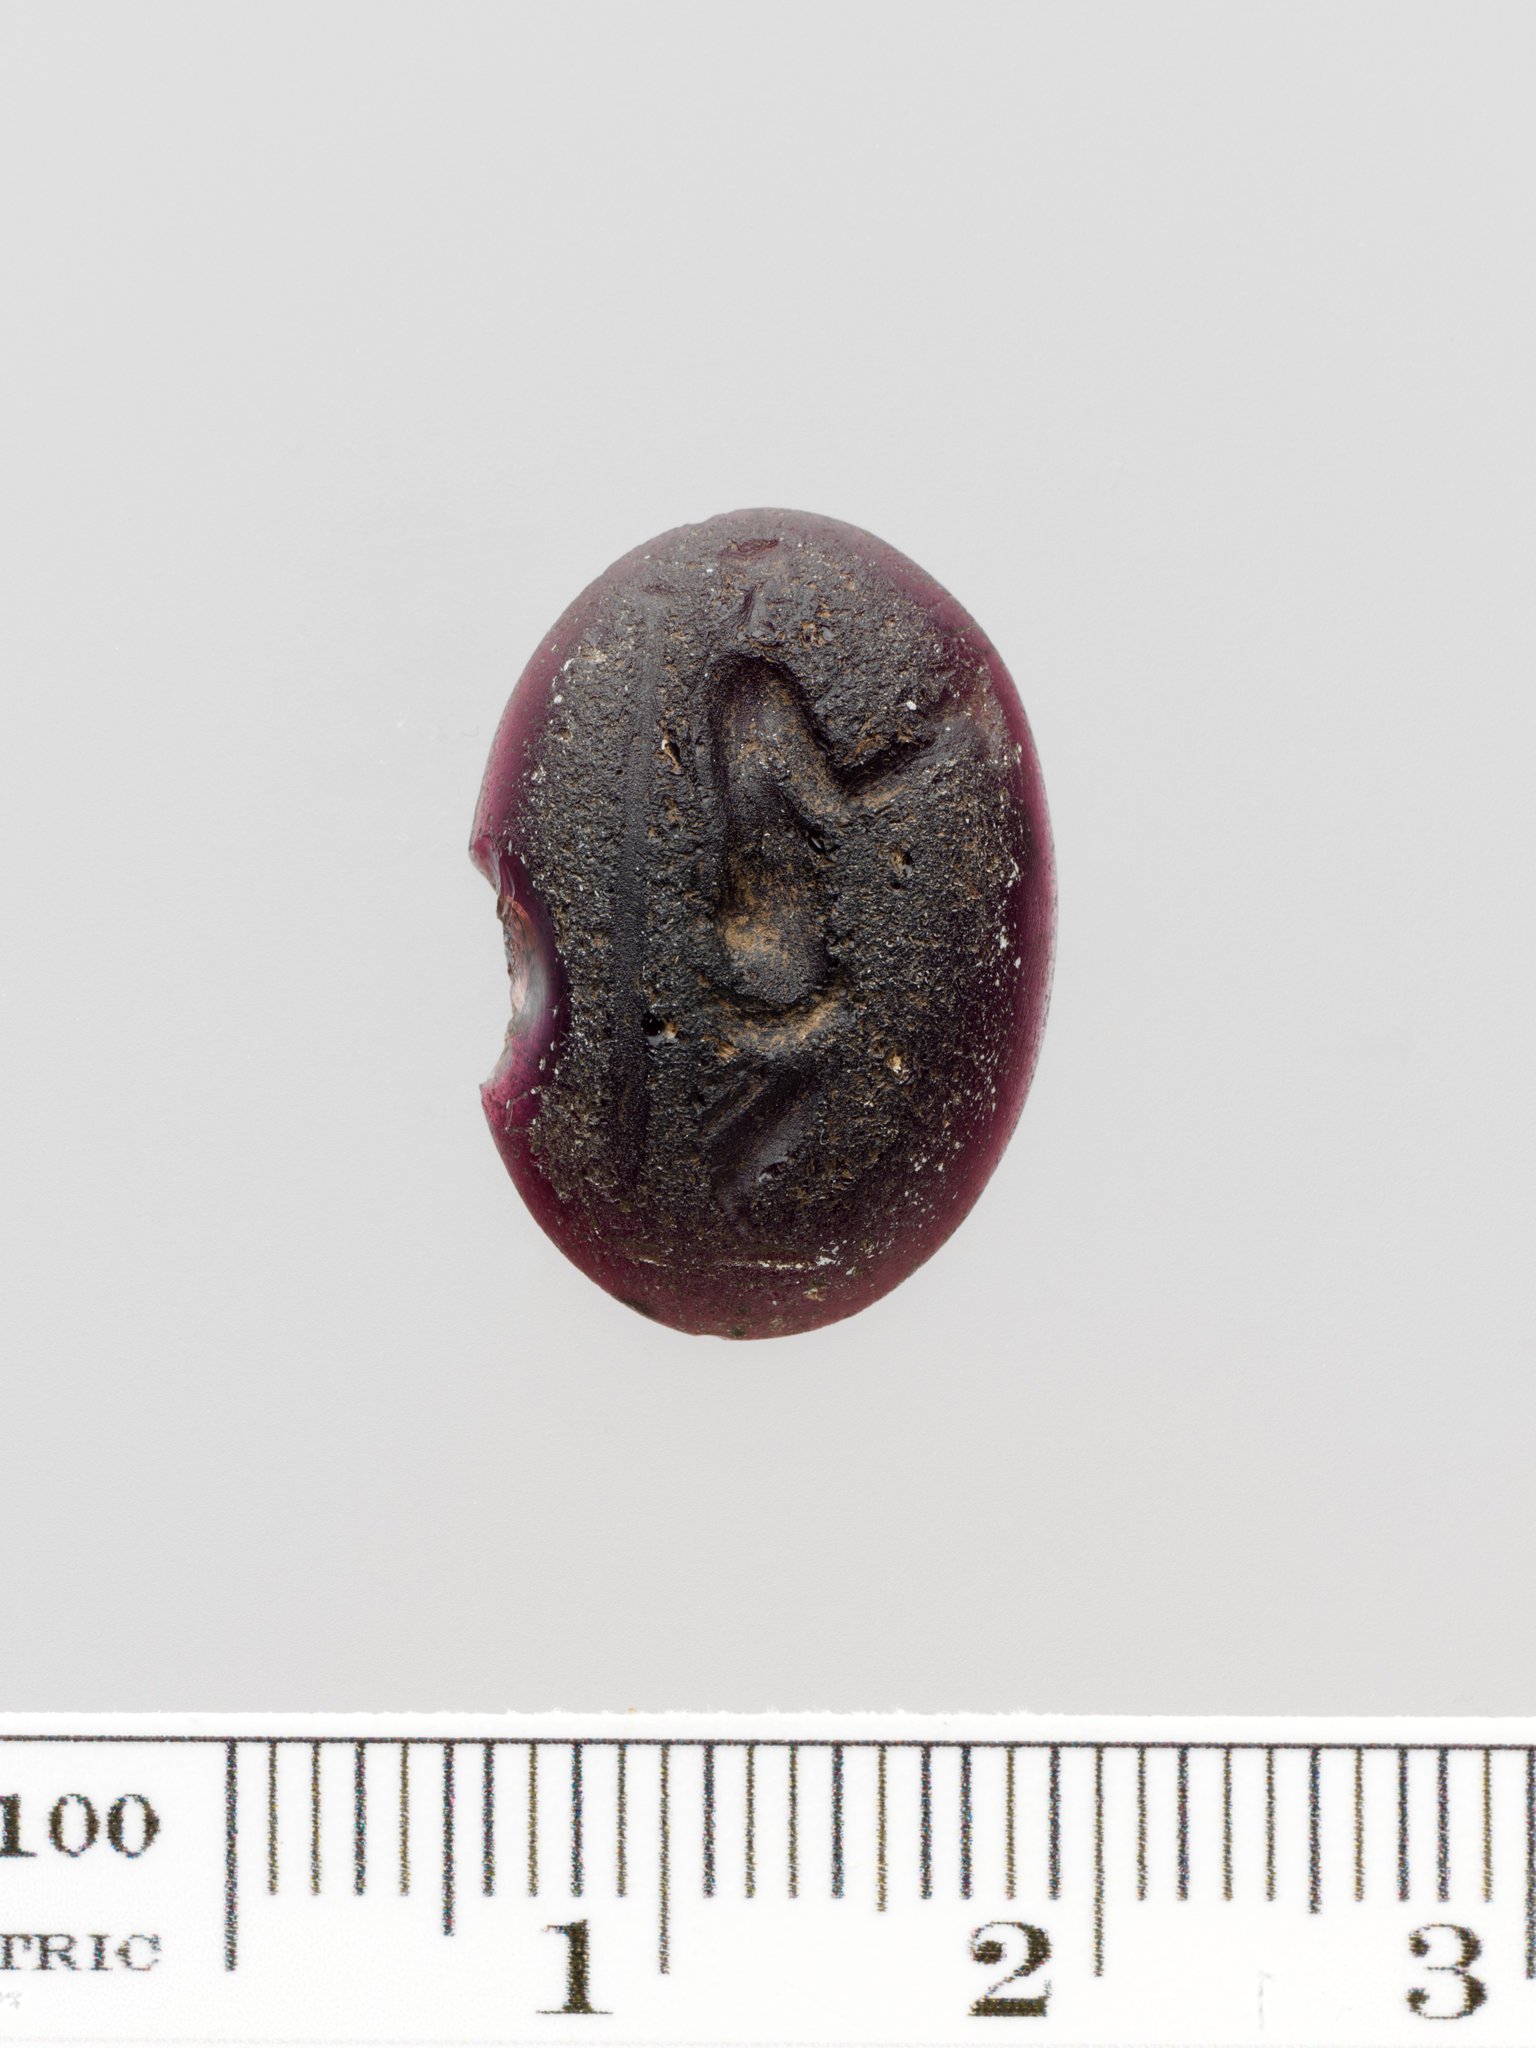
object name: intaglio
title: Glass ring stone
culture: roman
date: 100 BCE-300 CE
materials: glass, paste